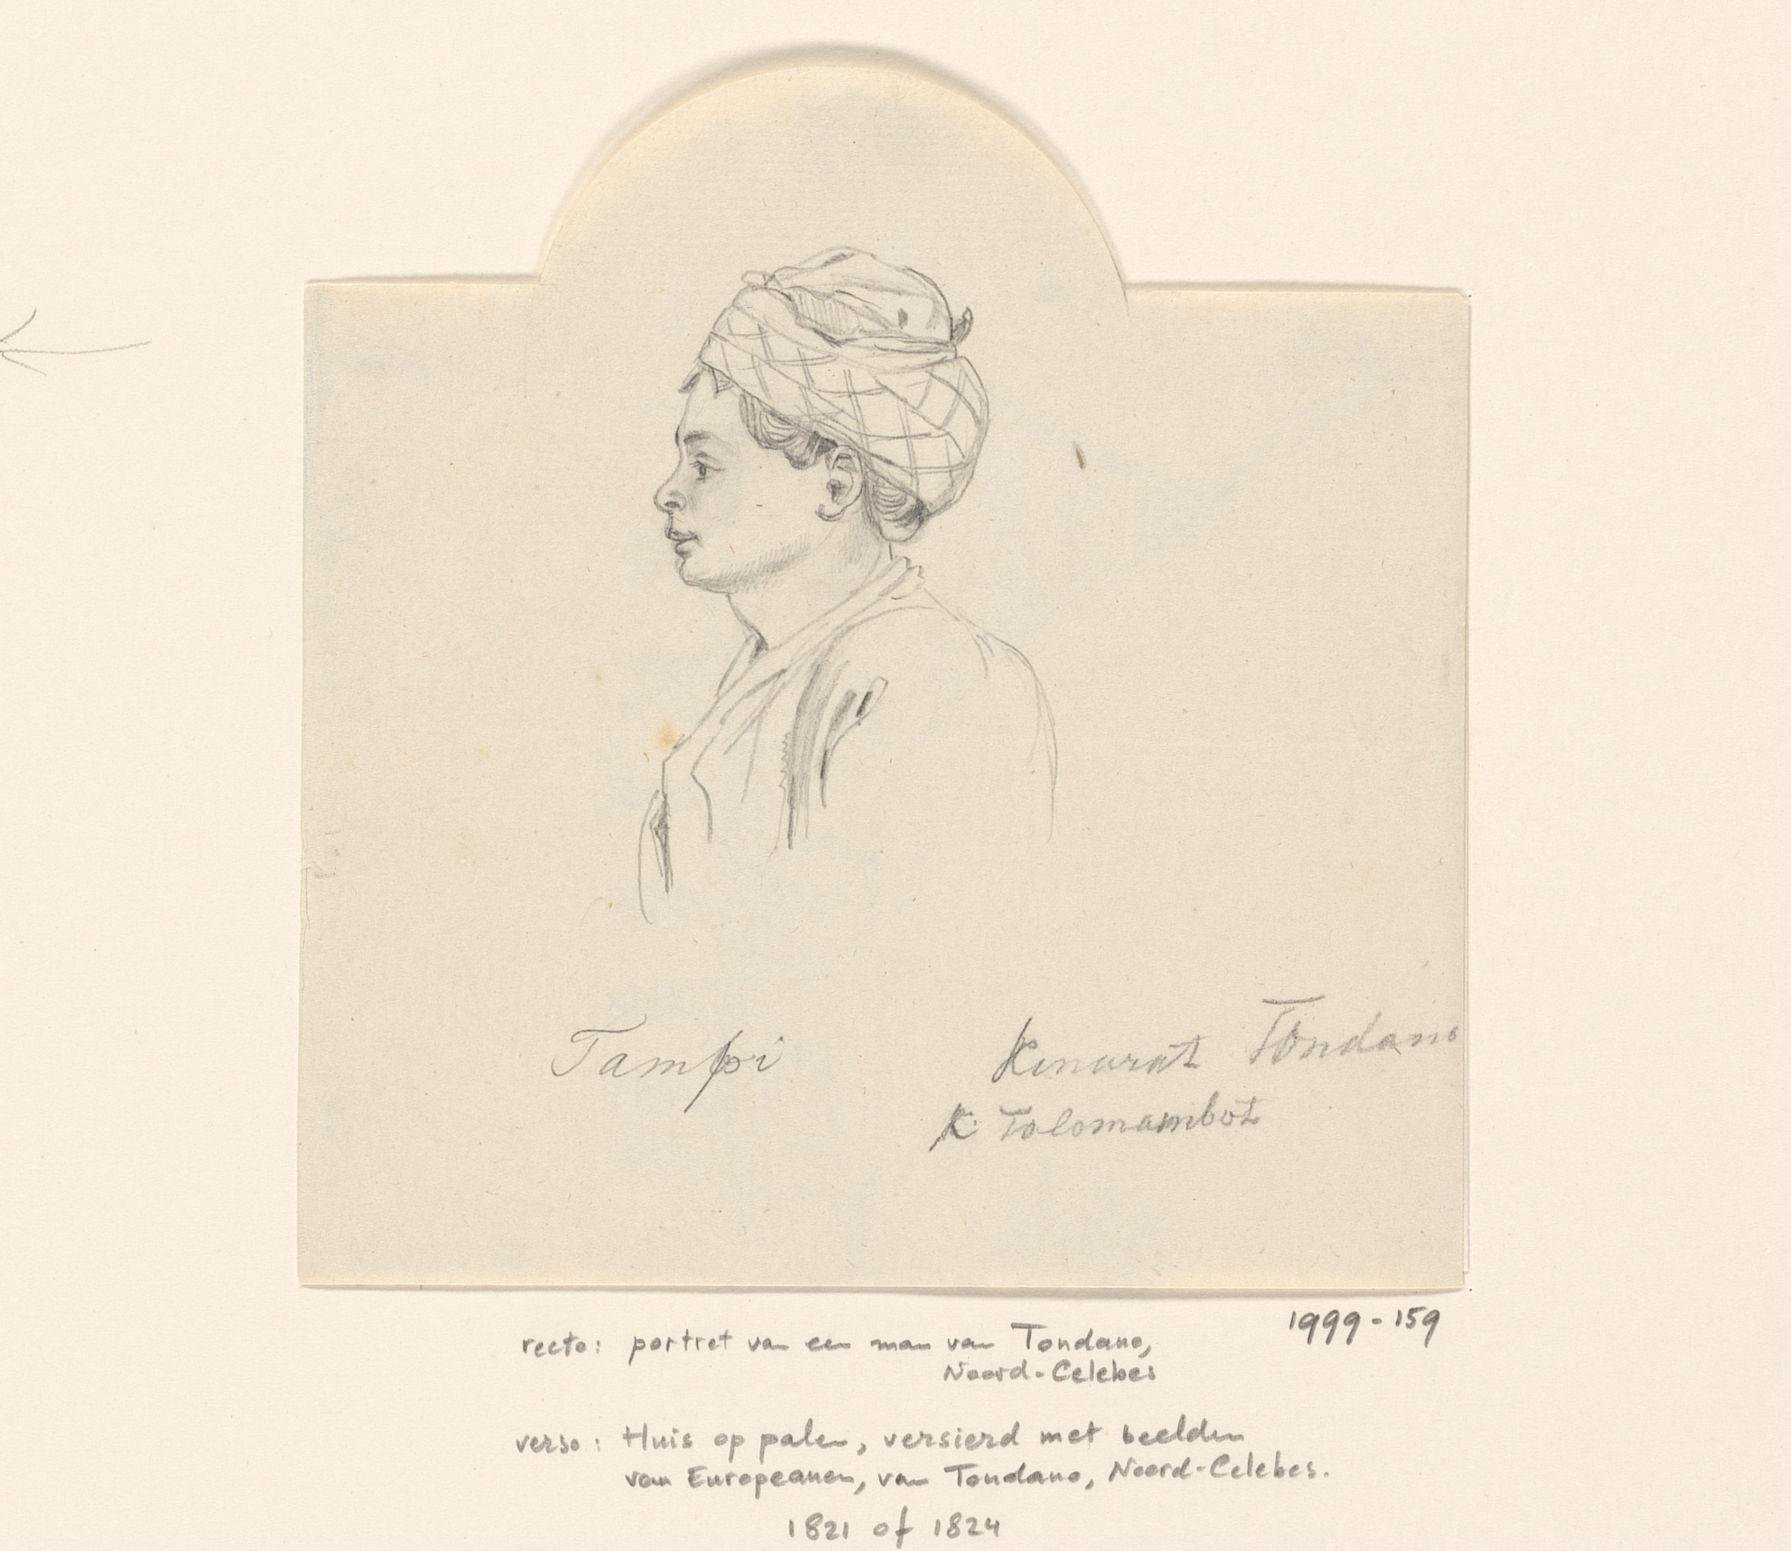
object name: drawing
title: Portret in profiel van Tampi, een man van Tondano, Noord-Celebes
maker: adrianus johannes bik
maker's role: draughtsman, print maker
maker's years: 1790-1872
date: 1821-1824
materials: paper, pencil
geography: north celebes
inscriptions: annotation: ‘Tampi / Kinarat [?] Tondano/k. Tolomambot[?]’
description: artikel over deze collectie in Bulletin van het Rijksmuseum 49 [2001], nr. 4, pp.343 e.v.